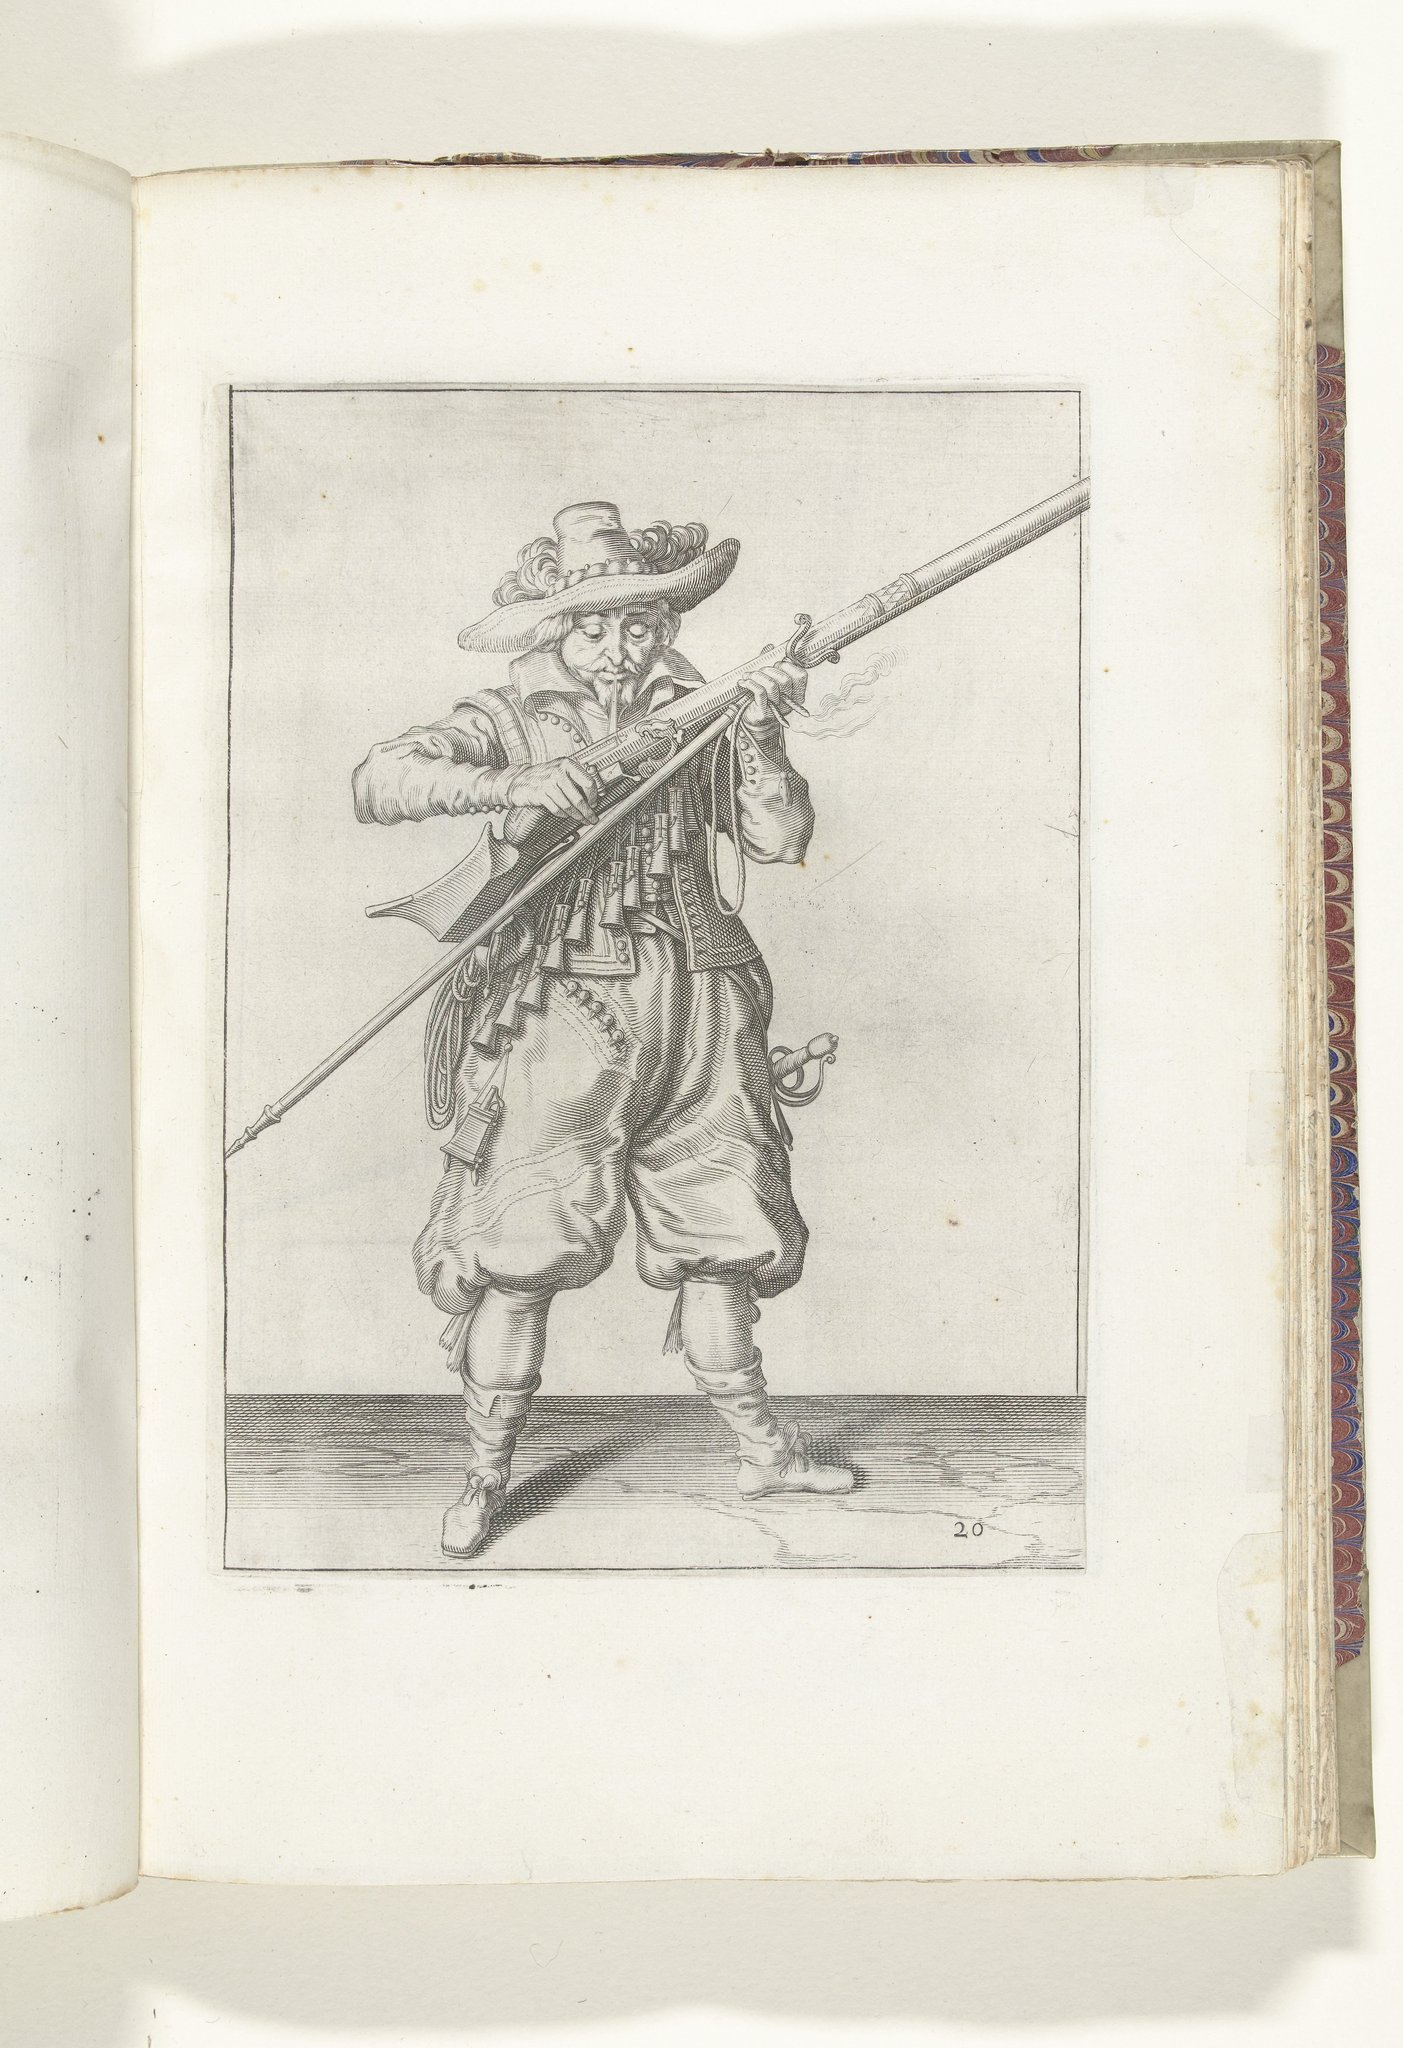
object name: print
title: Soldaat die kruit van zijn musket blaast (nr. 20), ca. 1600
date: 1597-1607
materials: paper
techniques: engraving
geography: amsterdam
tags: the hague, maurice (prince of orange), handling of weapons ~ military training, weapons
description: Een soldaat, ten voeten uit, die met beide handen een musket (een bepaald type vuurwapen) bij zijn mond houdt en erover blaast, om eventueel buiten de pan (het kruitreservoir) gevallen kruit ervan af te krijgen (nr. 20), ca. 1600. In zijn linkerhand behalve de loop van het musket ook een furket (musketvork) en een brandende lont. Plaat 20 in de instructies voor het hanteren van het musket: Corte onderrechtinghe op de figuerlicke afbeeldinghe, soo veel aengaet het recht ghebruyck van Musquet. Onderdeel van de illustraties in: J. de Gheyn, Wapenhandelinghe van Roers Musquetten ende spiessen, Amsterdam, 1608. Krijgswezen rond 1600.